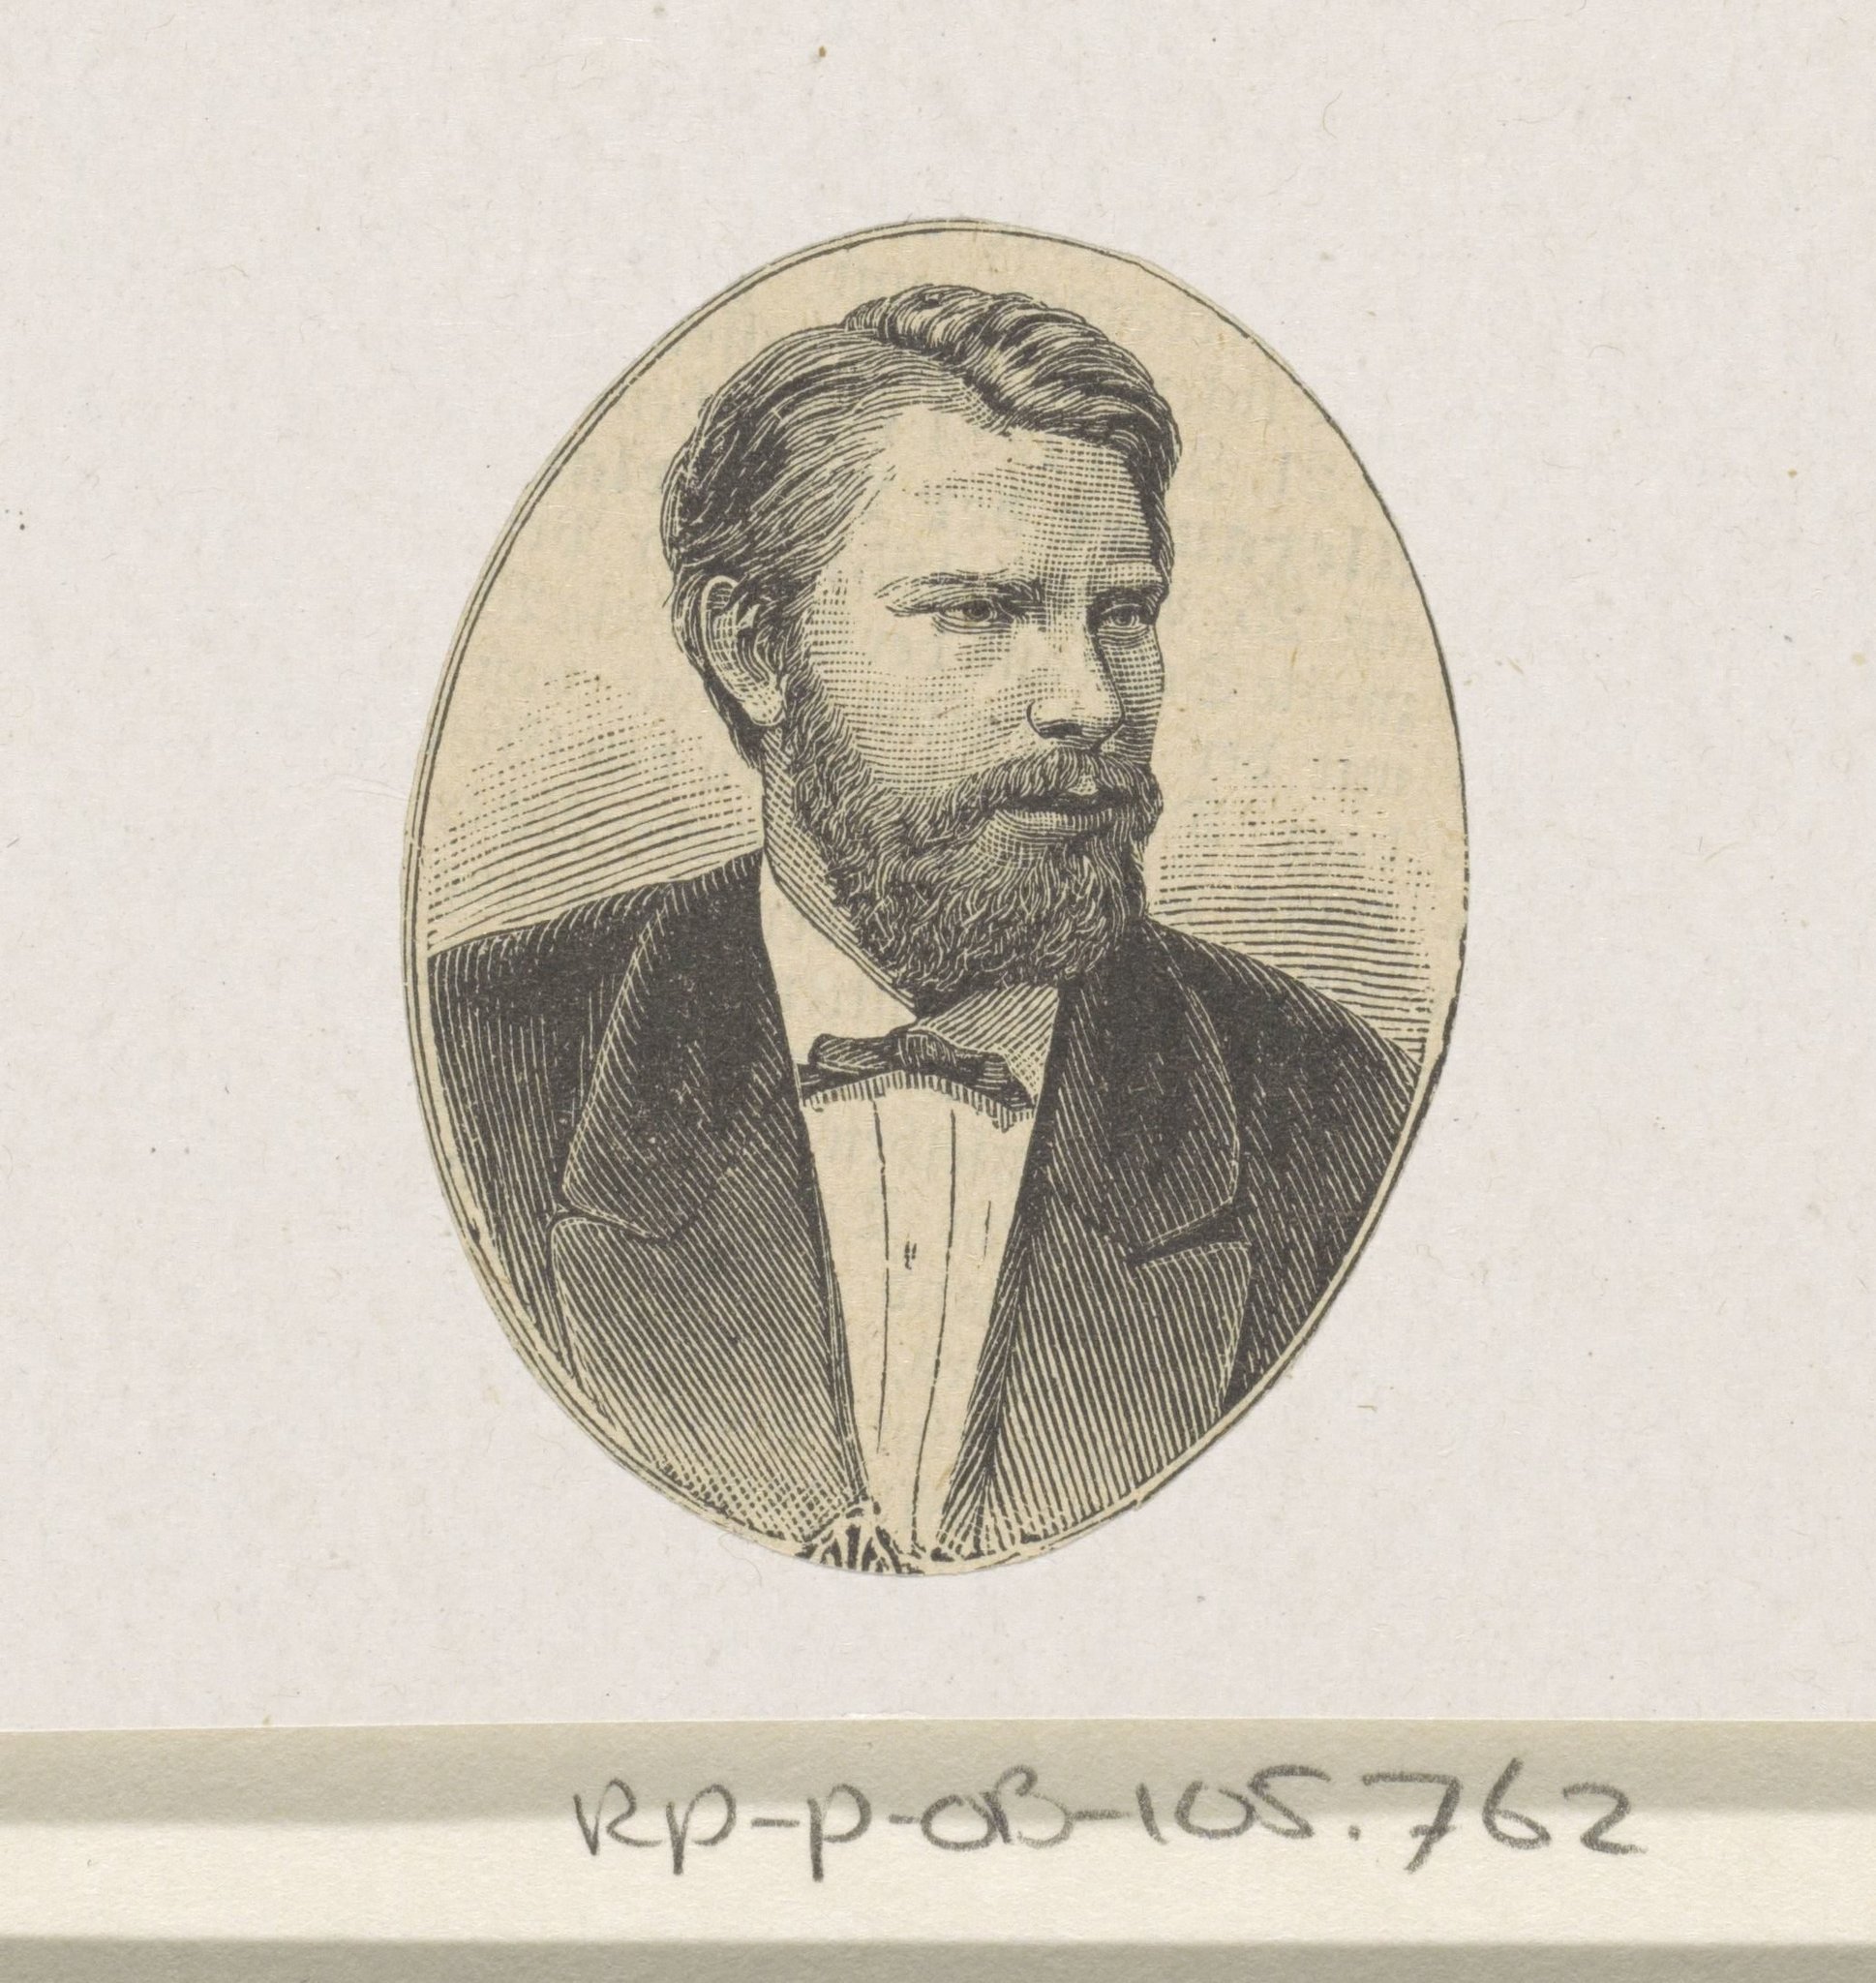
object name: book illustration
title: Portret van Alexander, prins der Nederlanden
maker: Anonymous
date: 1870-1949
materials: paper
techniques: letterpress printing, engraving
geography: netherlands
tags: prins, alexander (prins der nederlanden)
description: De hier vermelde titel verwijst naar de hoogst verkregen titel van de geportretteerde, niet per se naar de titel die de geportretteerde op deze voorstelling draagt.